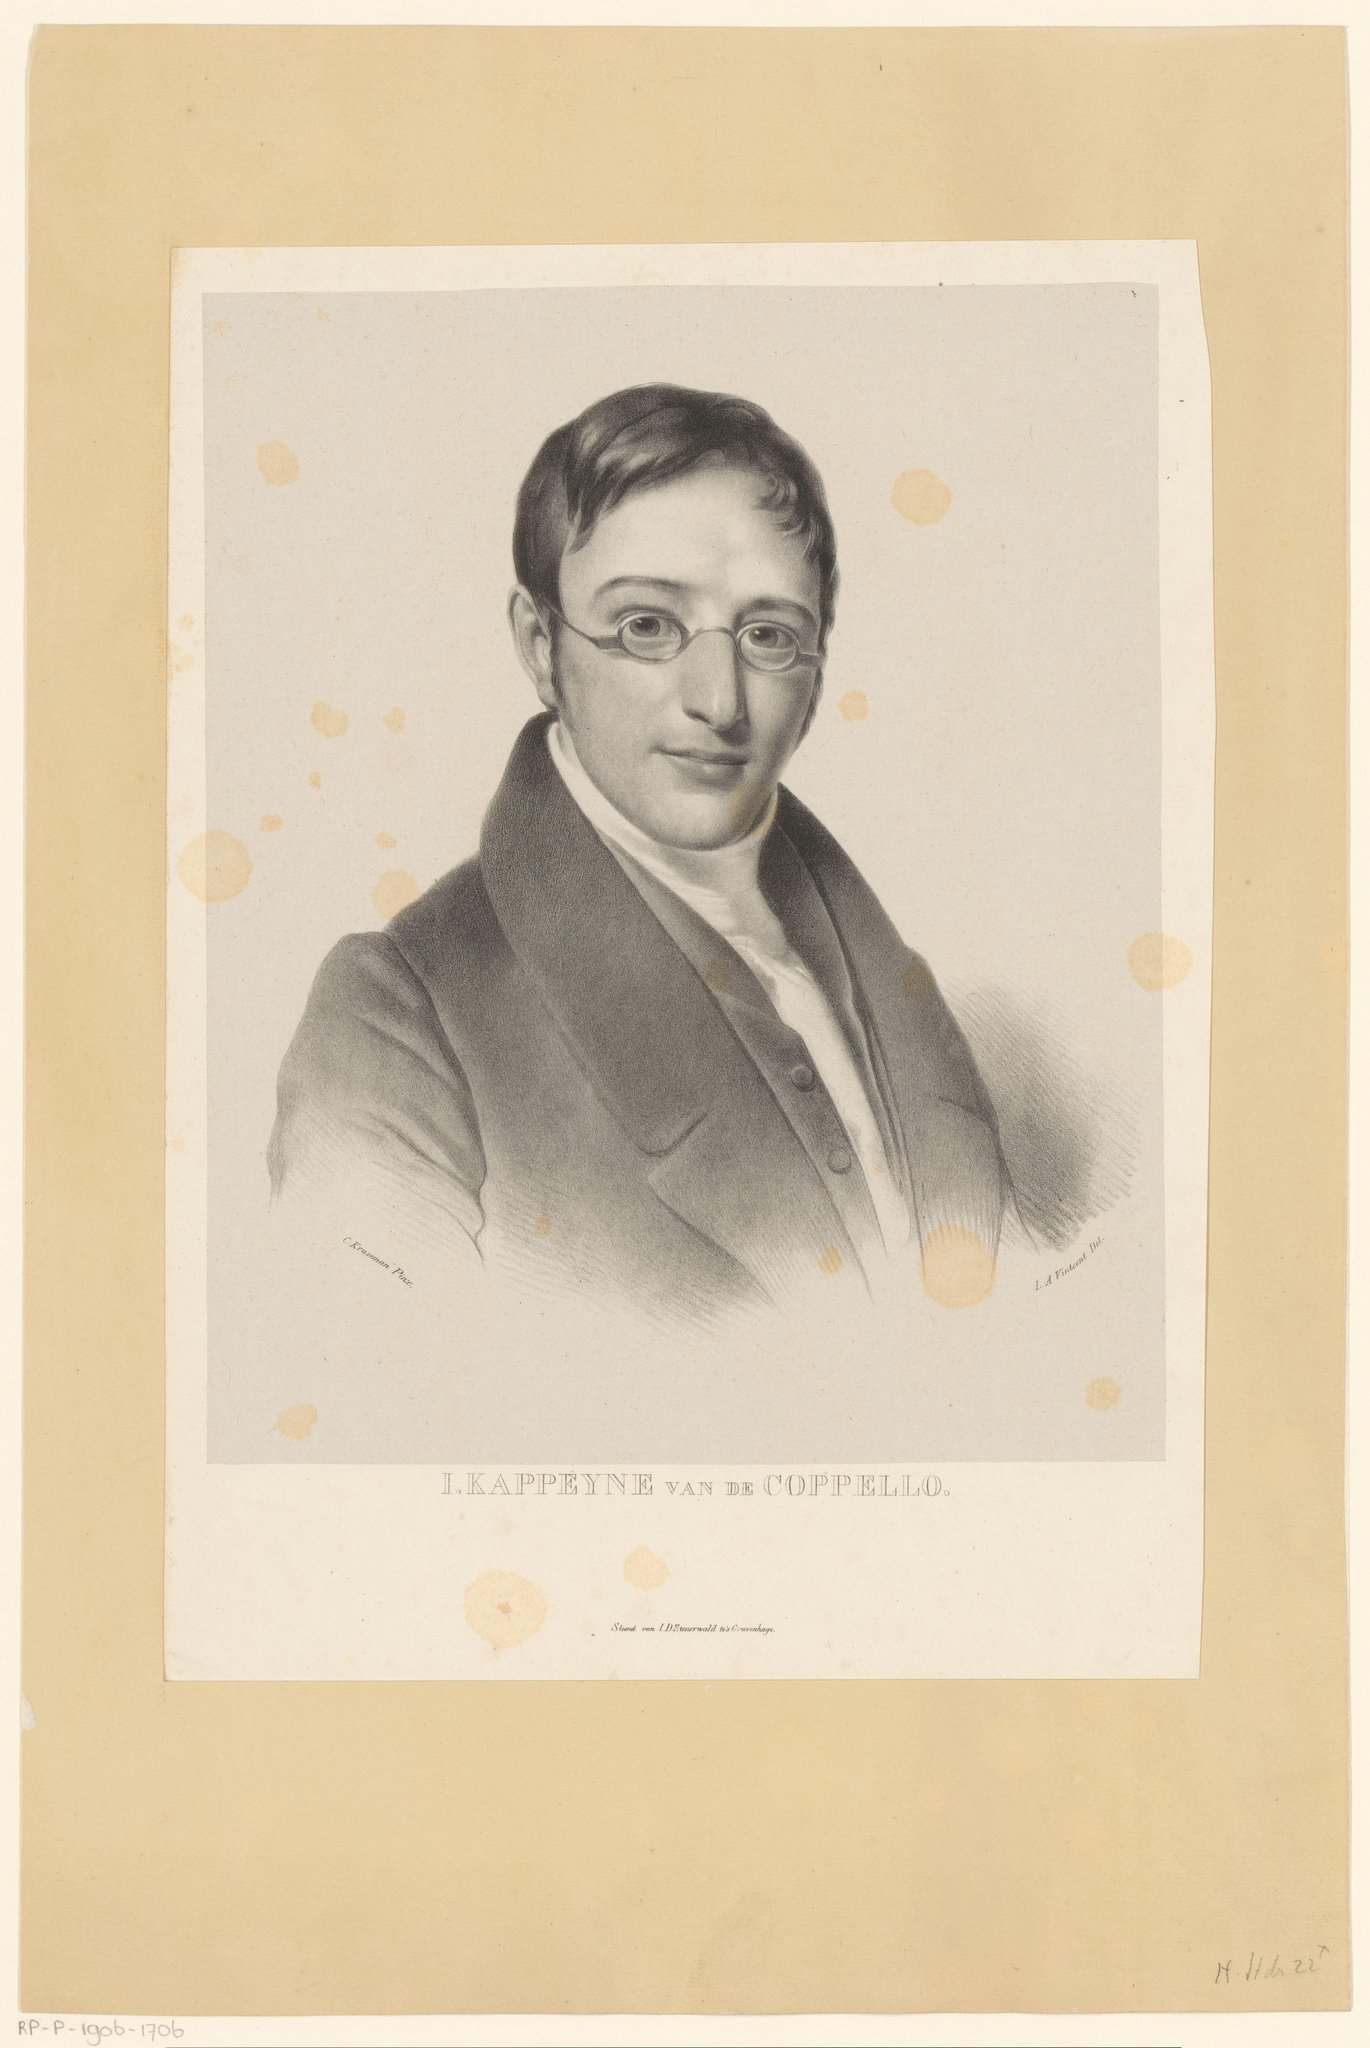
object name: print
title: I. Kappeyne van de Coppello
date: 1833-1842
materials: paper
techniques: lithograph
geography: the hague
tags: the hague, historical persons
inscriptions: collector's mark: Lugt 2228